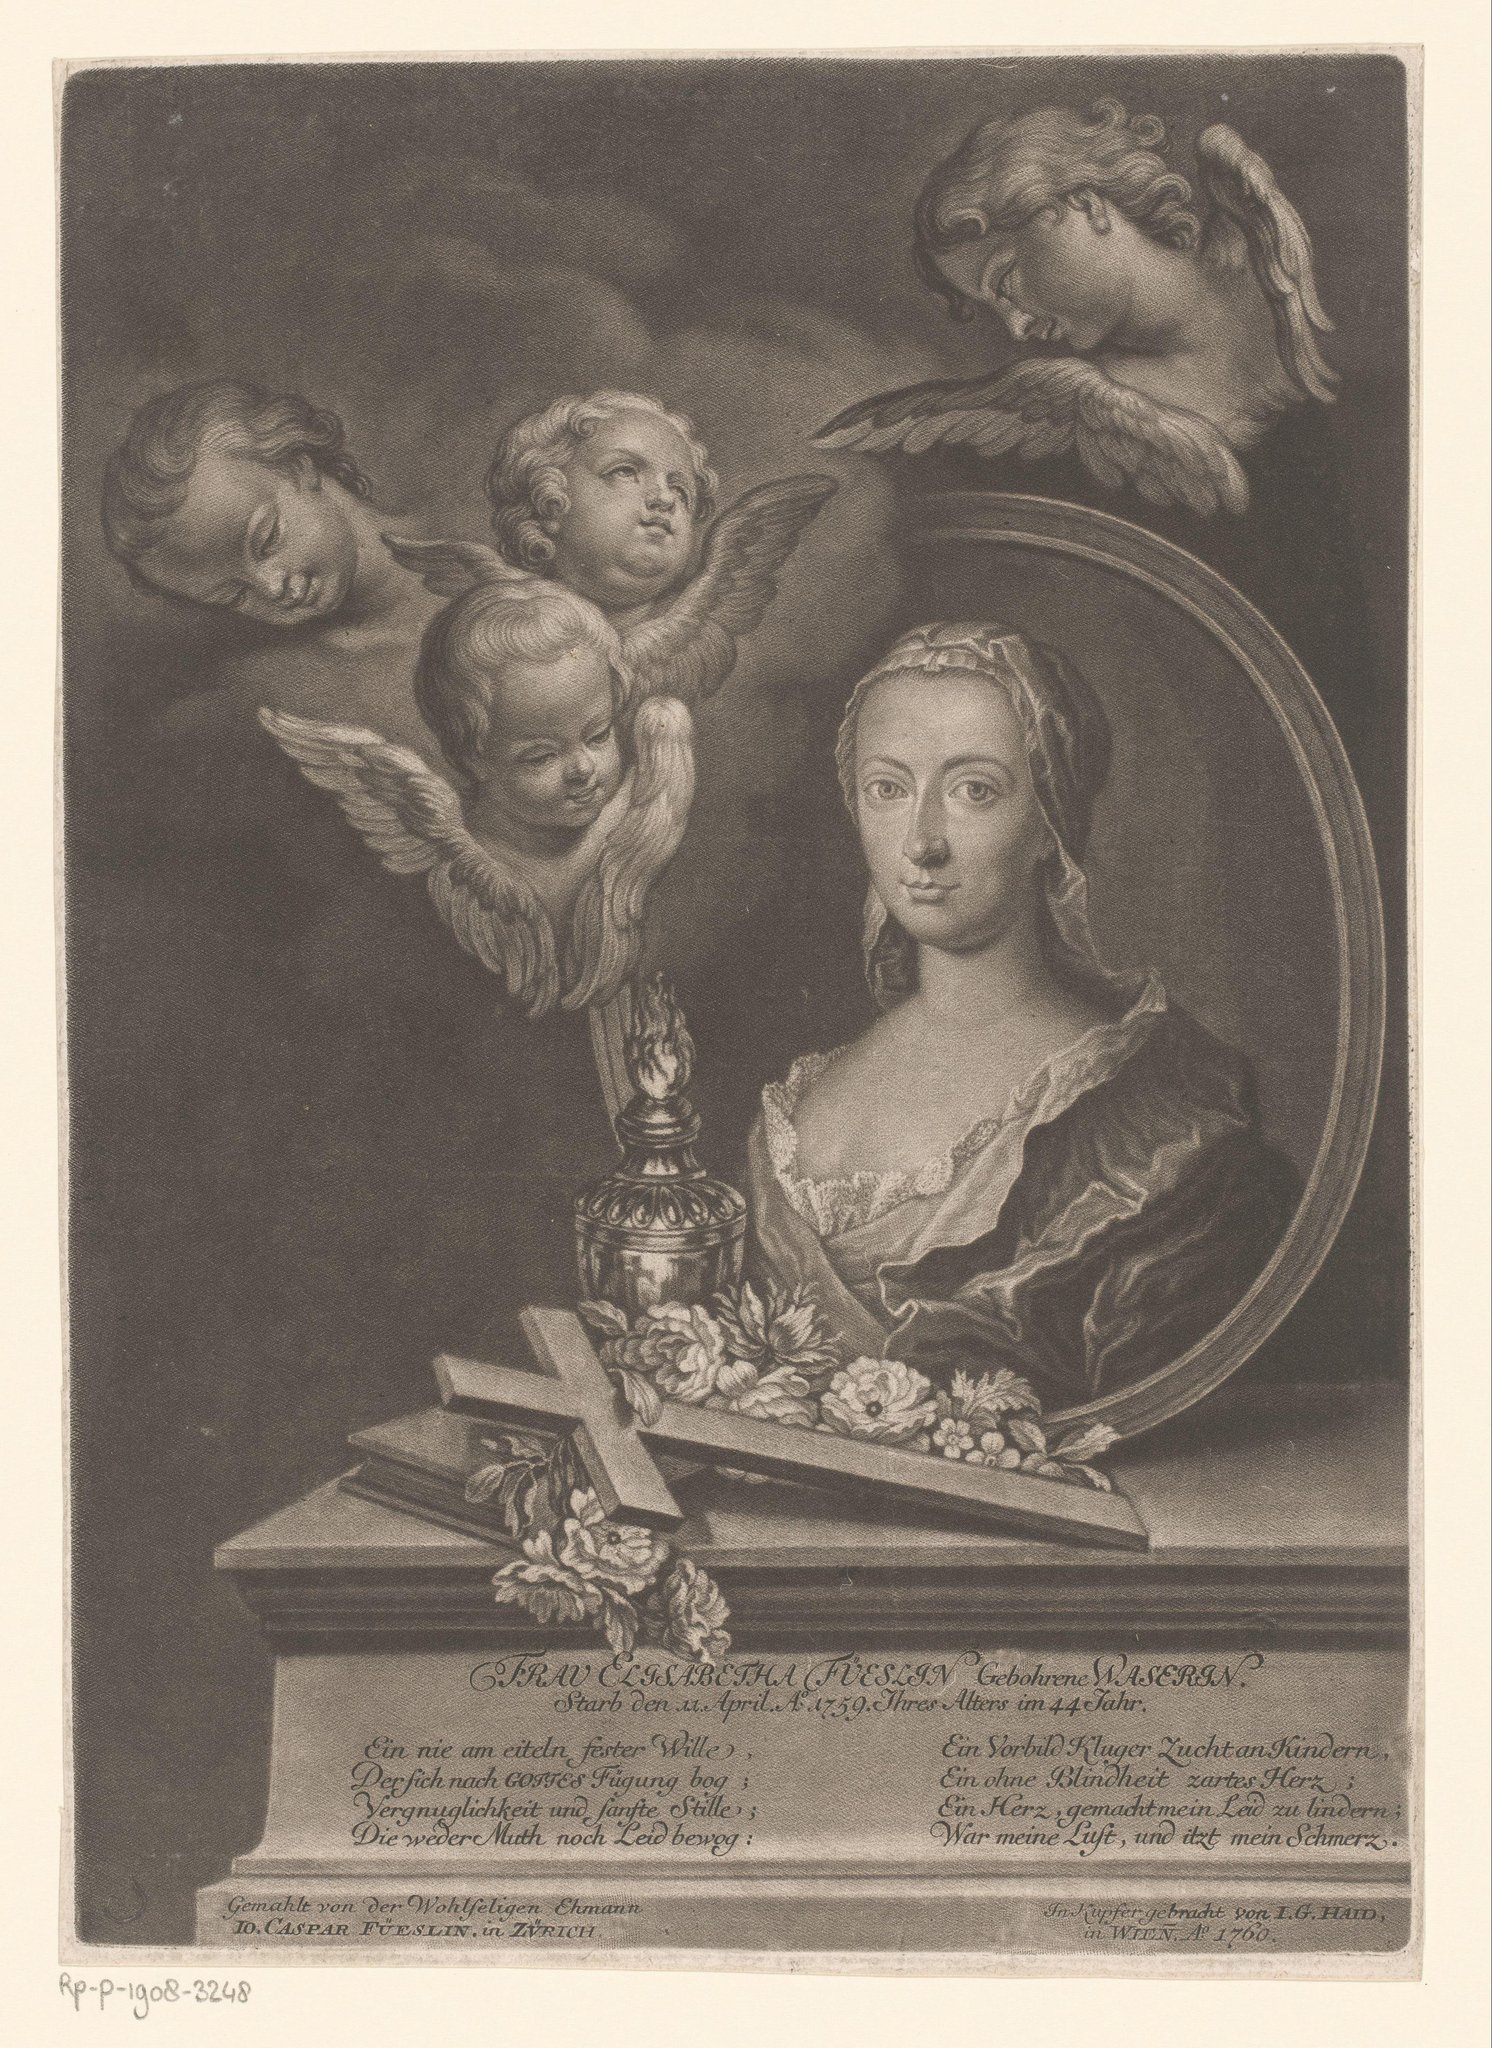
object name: print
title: Portret van Elisabeth Füssli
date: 1760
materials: paper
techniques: mezzotint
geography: vienna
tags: historical persons - bb - woman, symbols of death, cupids: 'amores', 'amoretti', 'putti'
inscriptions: collector's mark: Lugt 2228